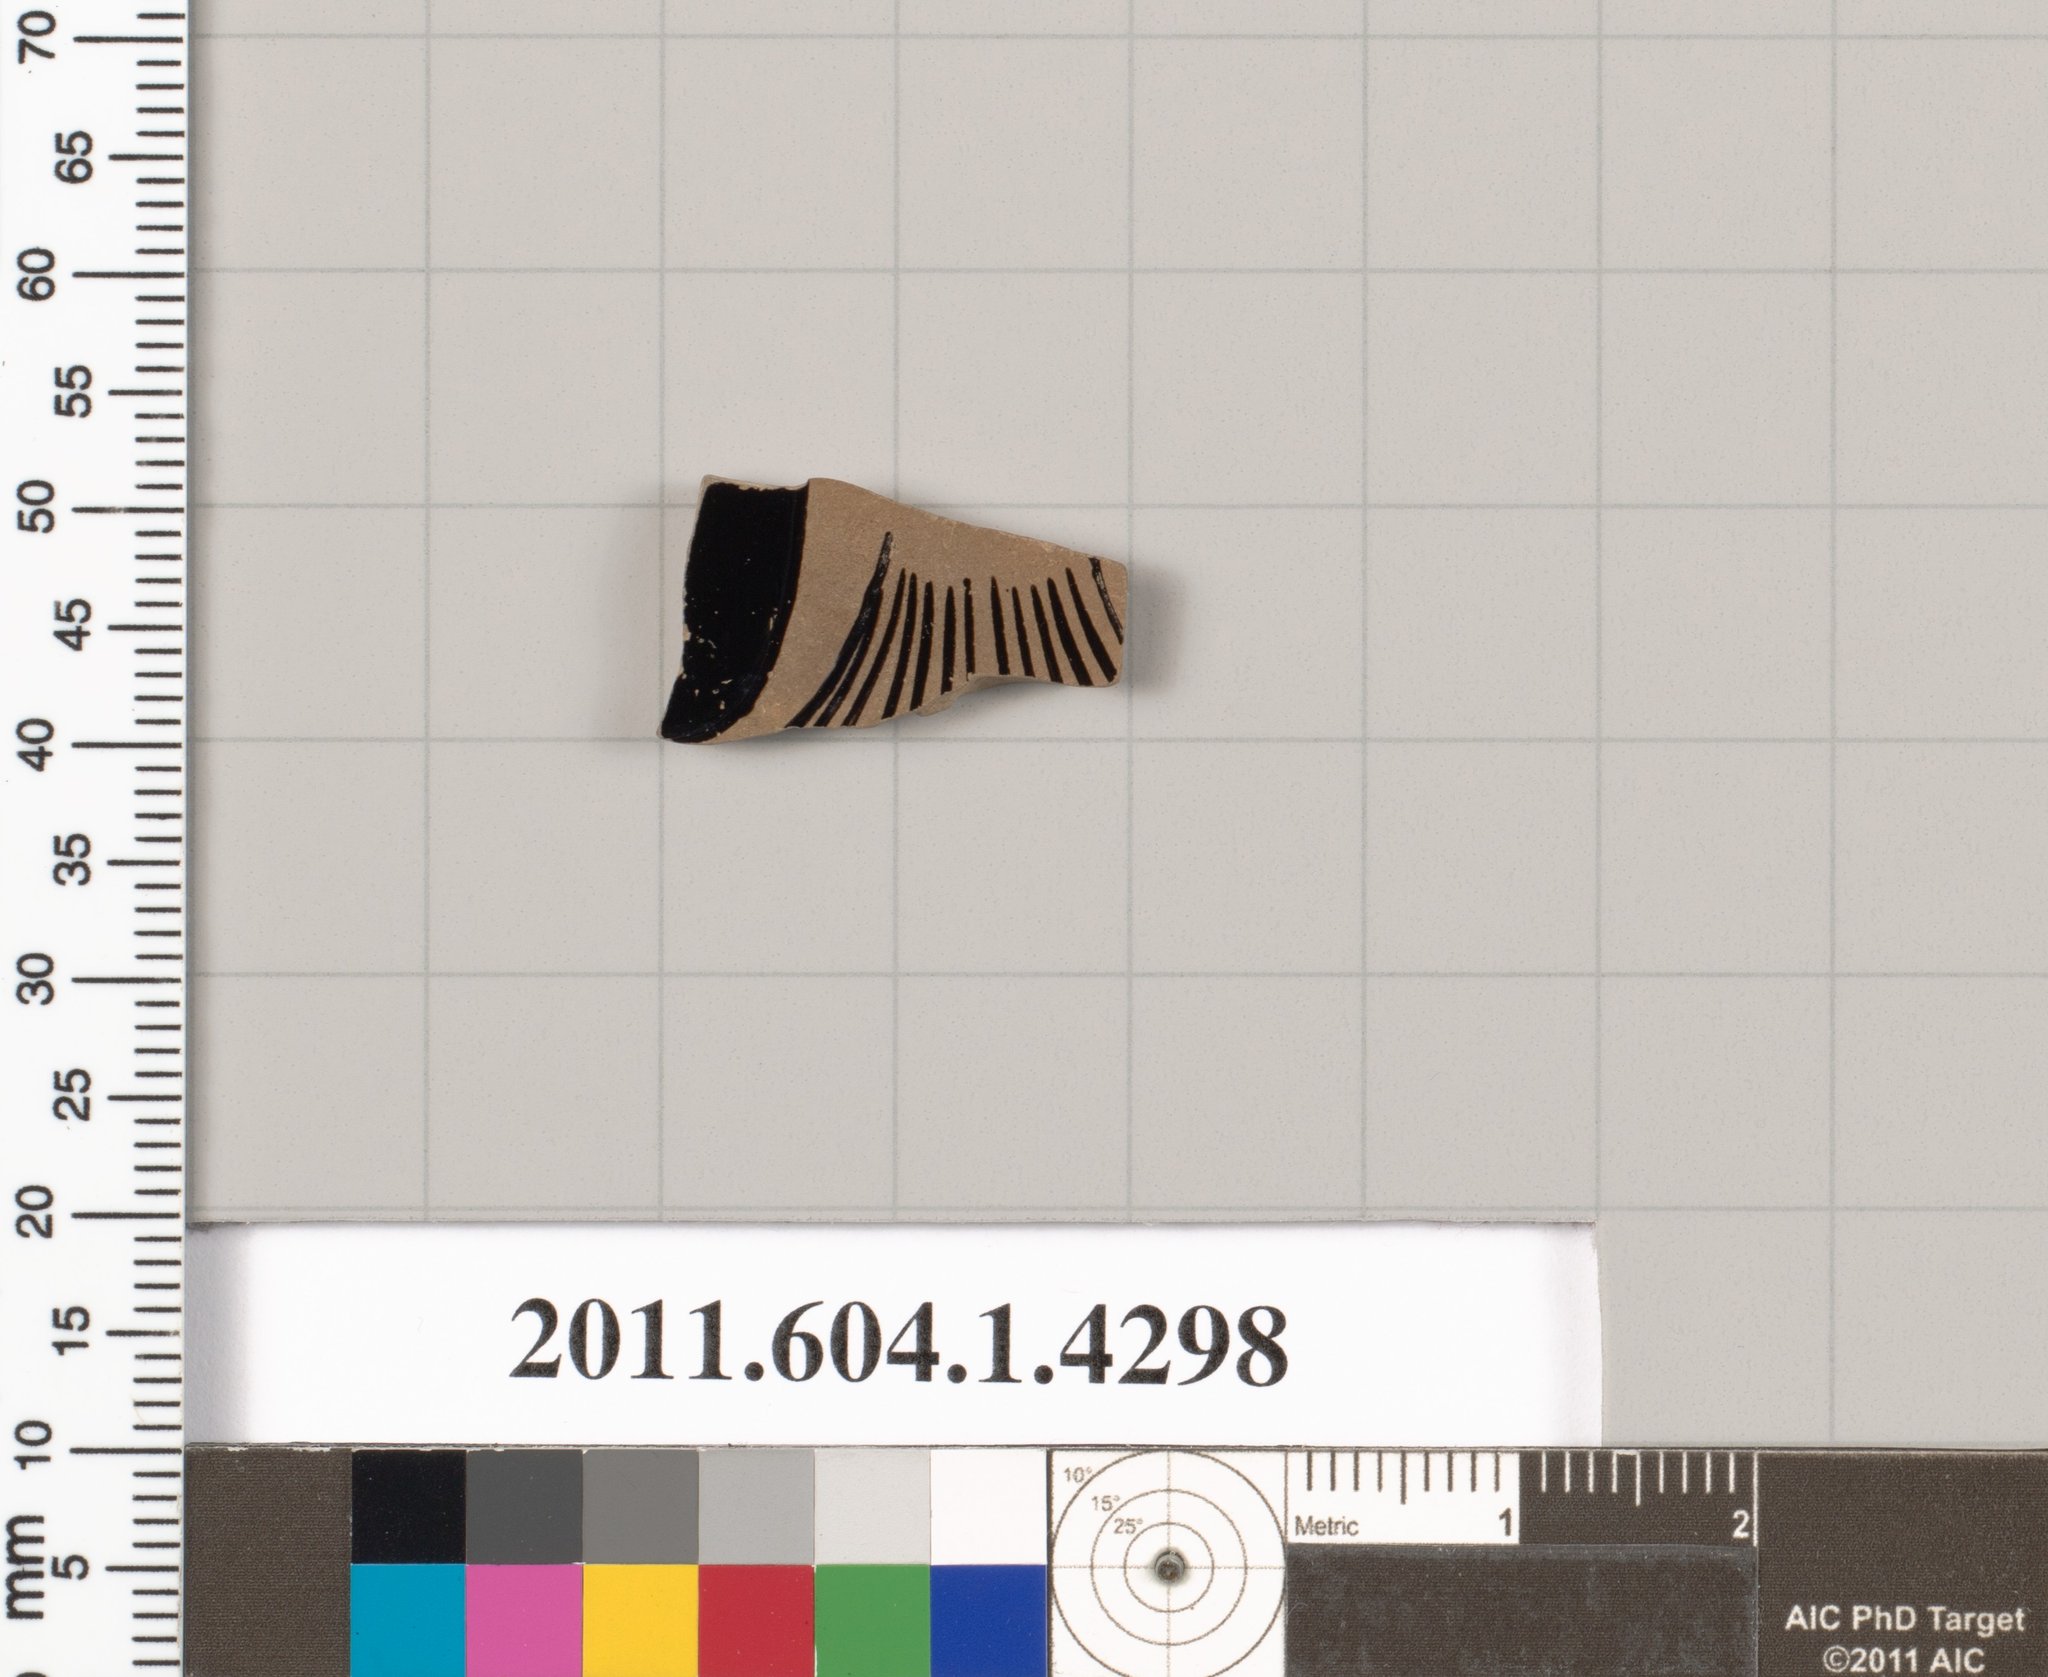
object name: kylix fragment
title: Terracotta fragment of a kylix (drinking cup)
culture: greek, attic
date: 500-480 BCE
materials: terracotta